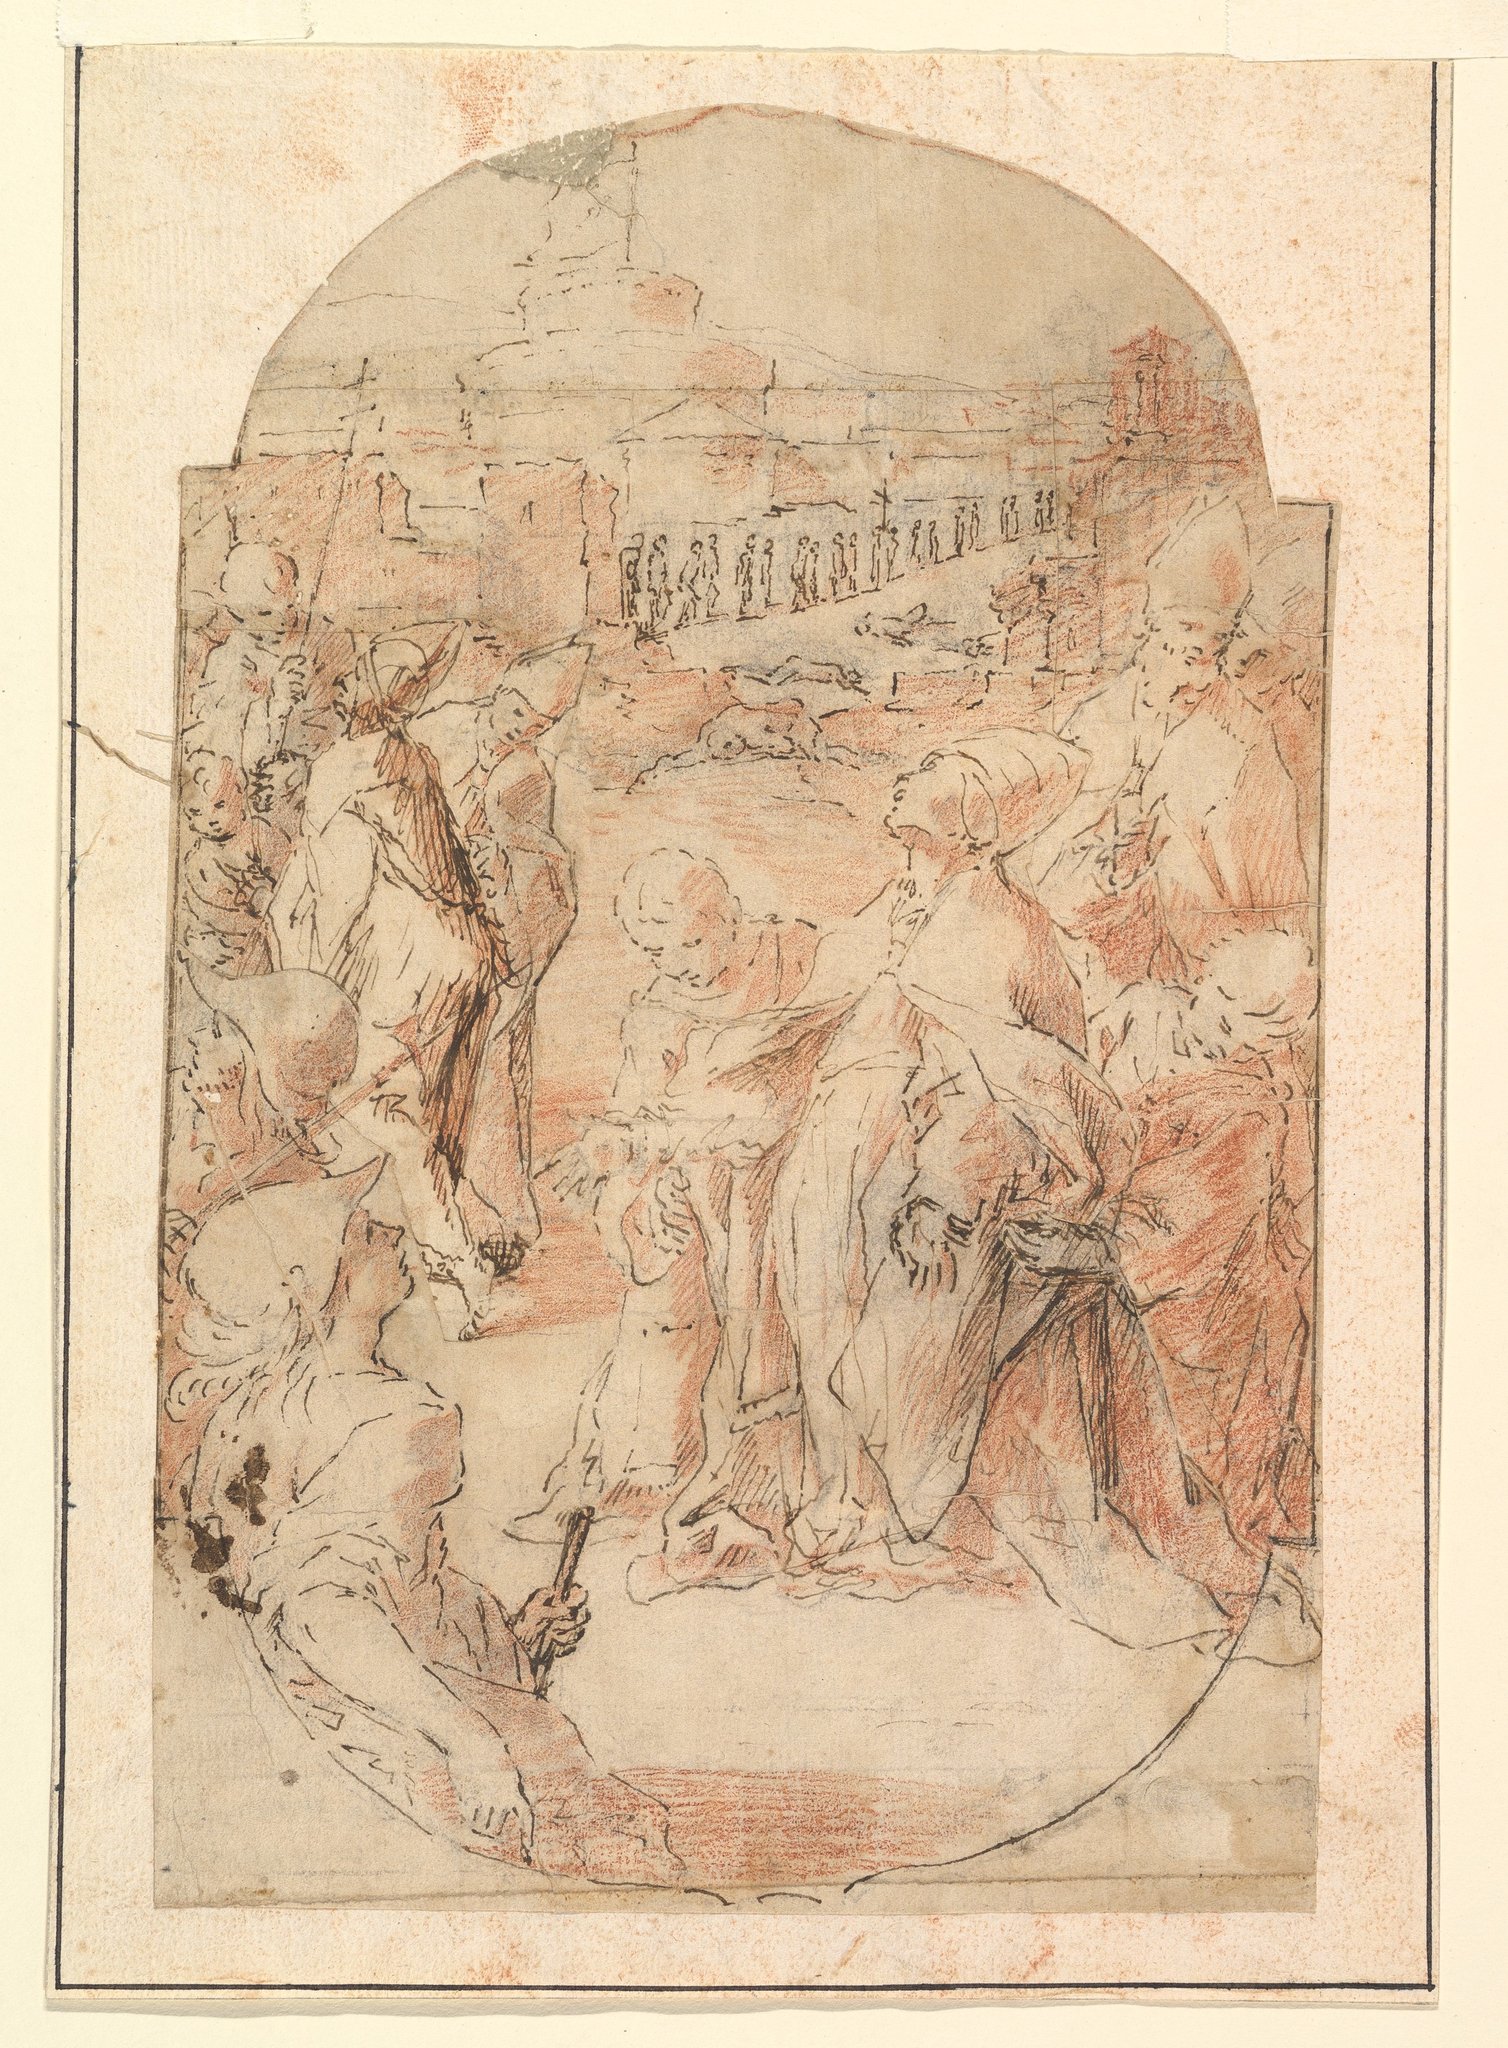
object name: drawing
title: The Consecration of the Site of a Church in Rome by a Pope ("The Miracle of Saint Mary of the Snows"?)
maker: giovanni lanfranco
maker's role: artist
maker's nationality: italian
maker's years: 1582-1647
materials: chalk, ink, paper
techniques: pen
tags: human figures,churches,popes,saints